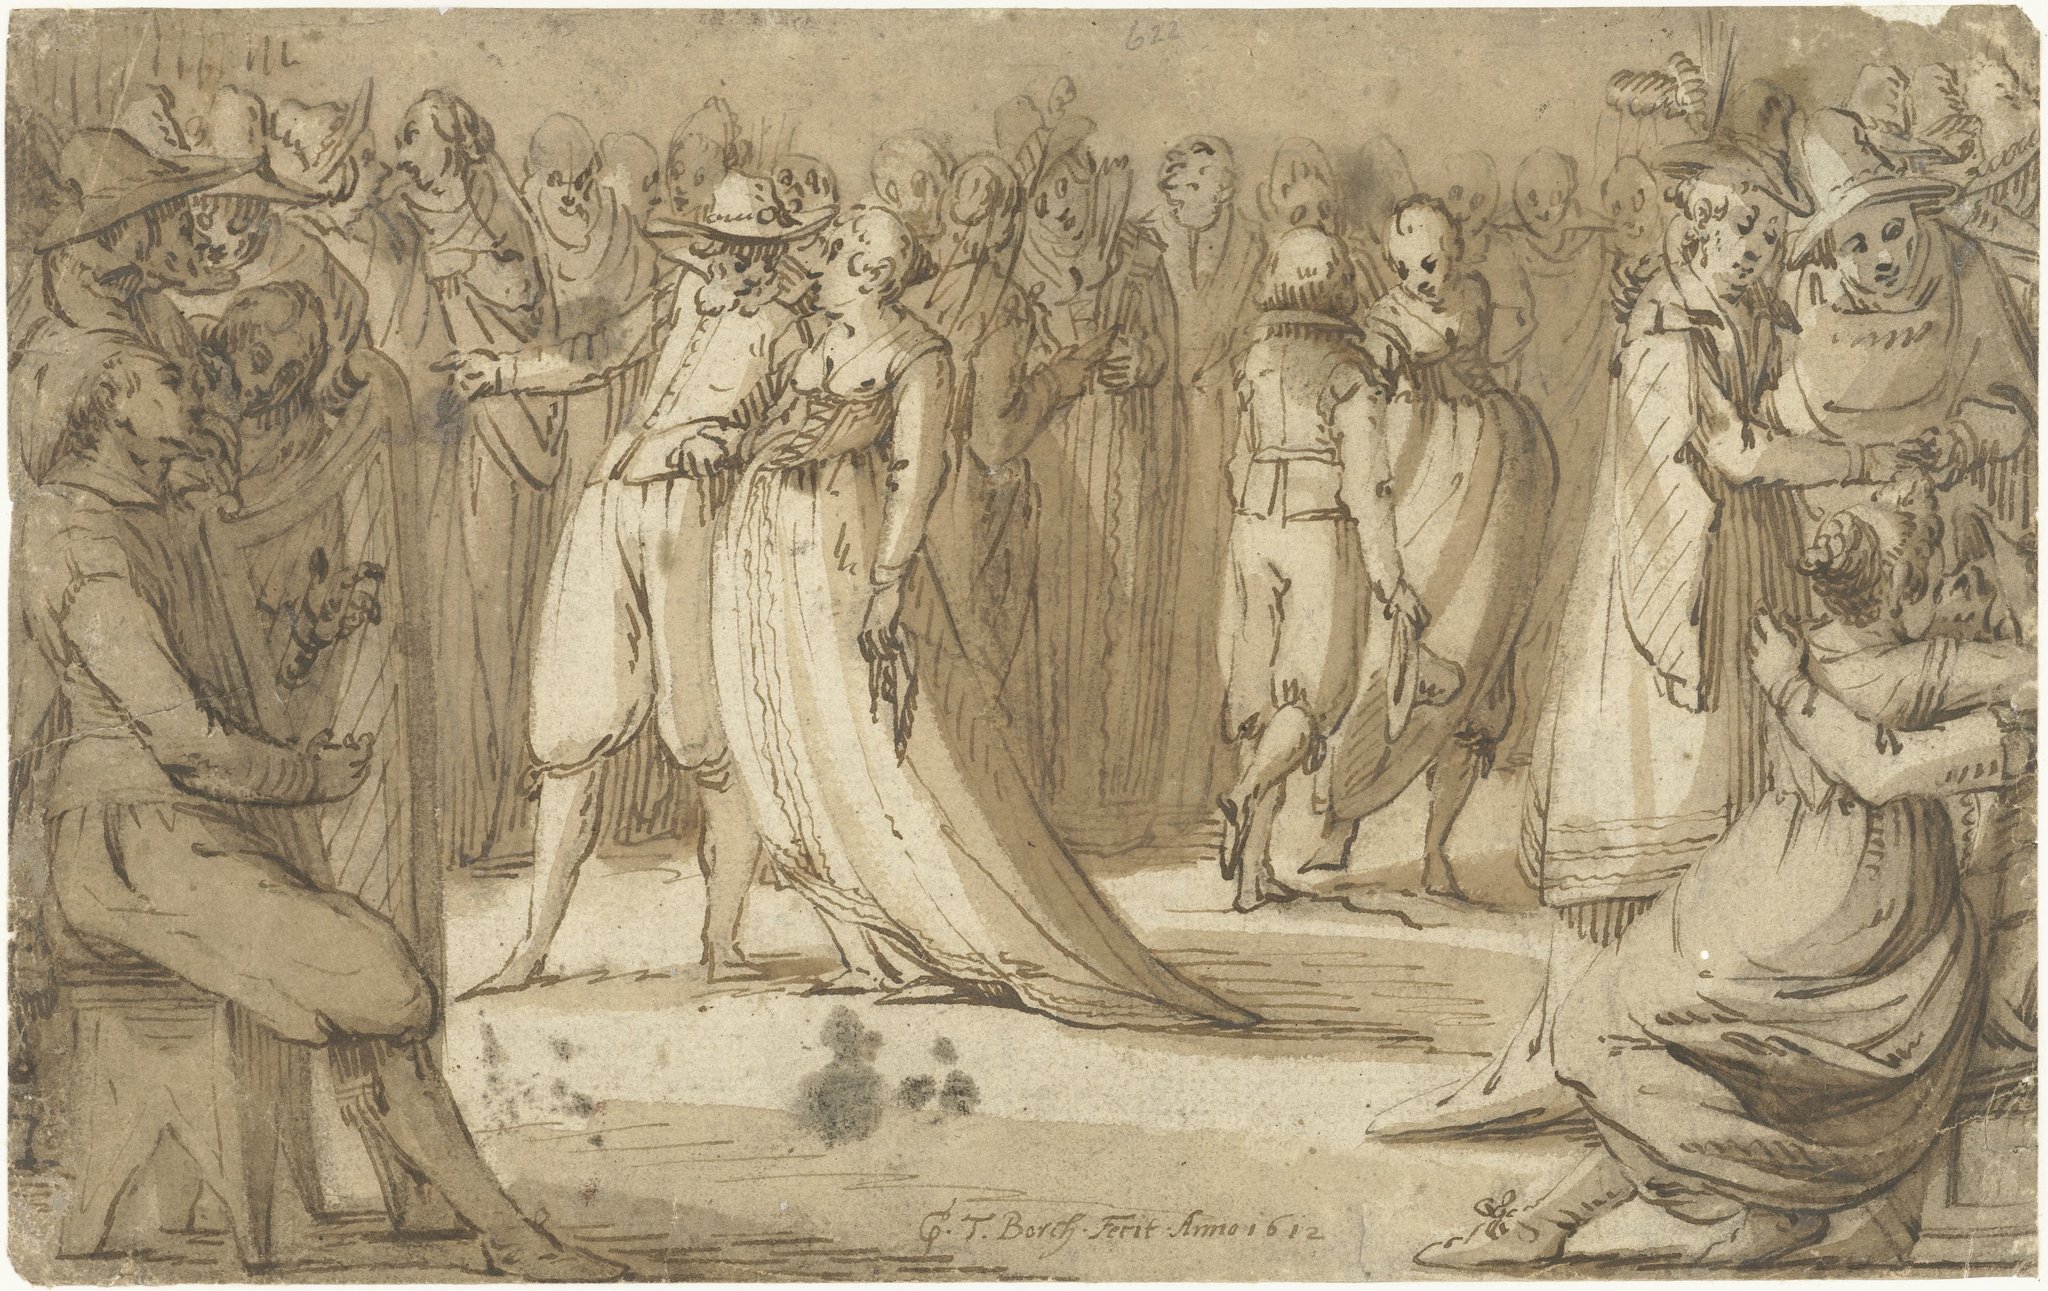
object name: drawing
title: Feestscène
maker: gerard ter borch (i)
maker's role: draughtsman, print maker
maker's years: 1584-1662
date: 1612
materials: chalk, ink, paper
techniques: brush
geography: zwolle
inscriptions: annotation: ‘G.T.Borch Sr.’, signature and date: ‘G.T.Borch.Fecit. Anno 1619’